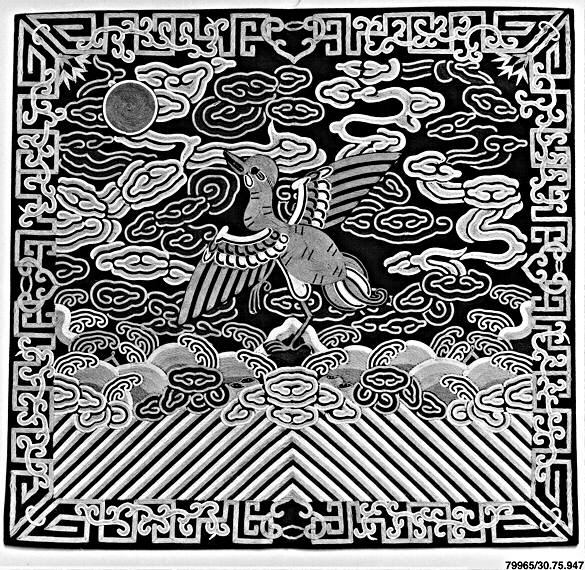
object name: rank badge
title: Rank Badge with Wild Goose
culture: chinese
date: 1801-1900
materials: silk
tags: geese